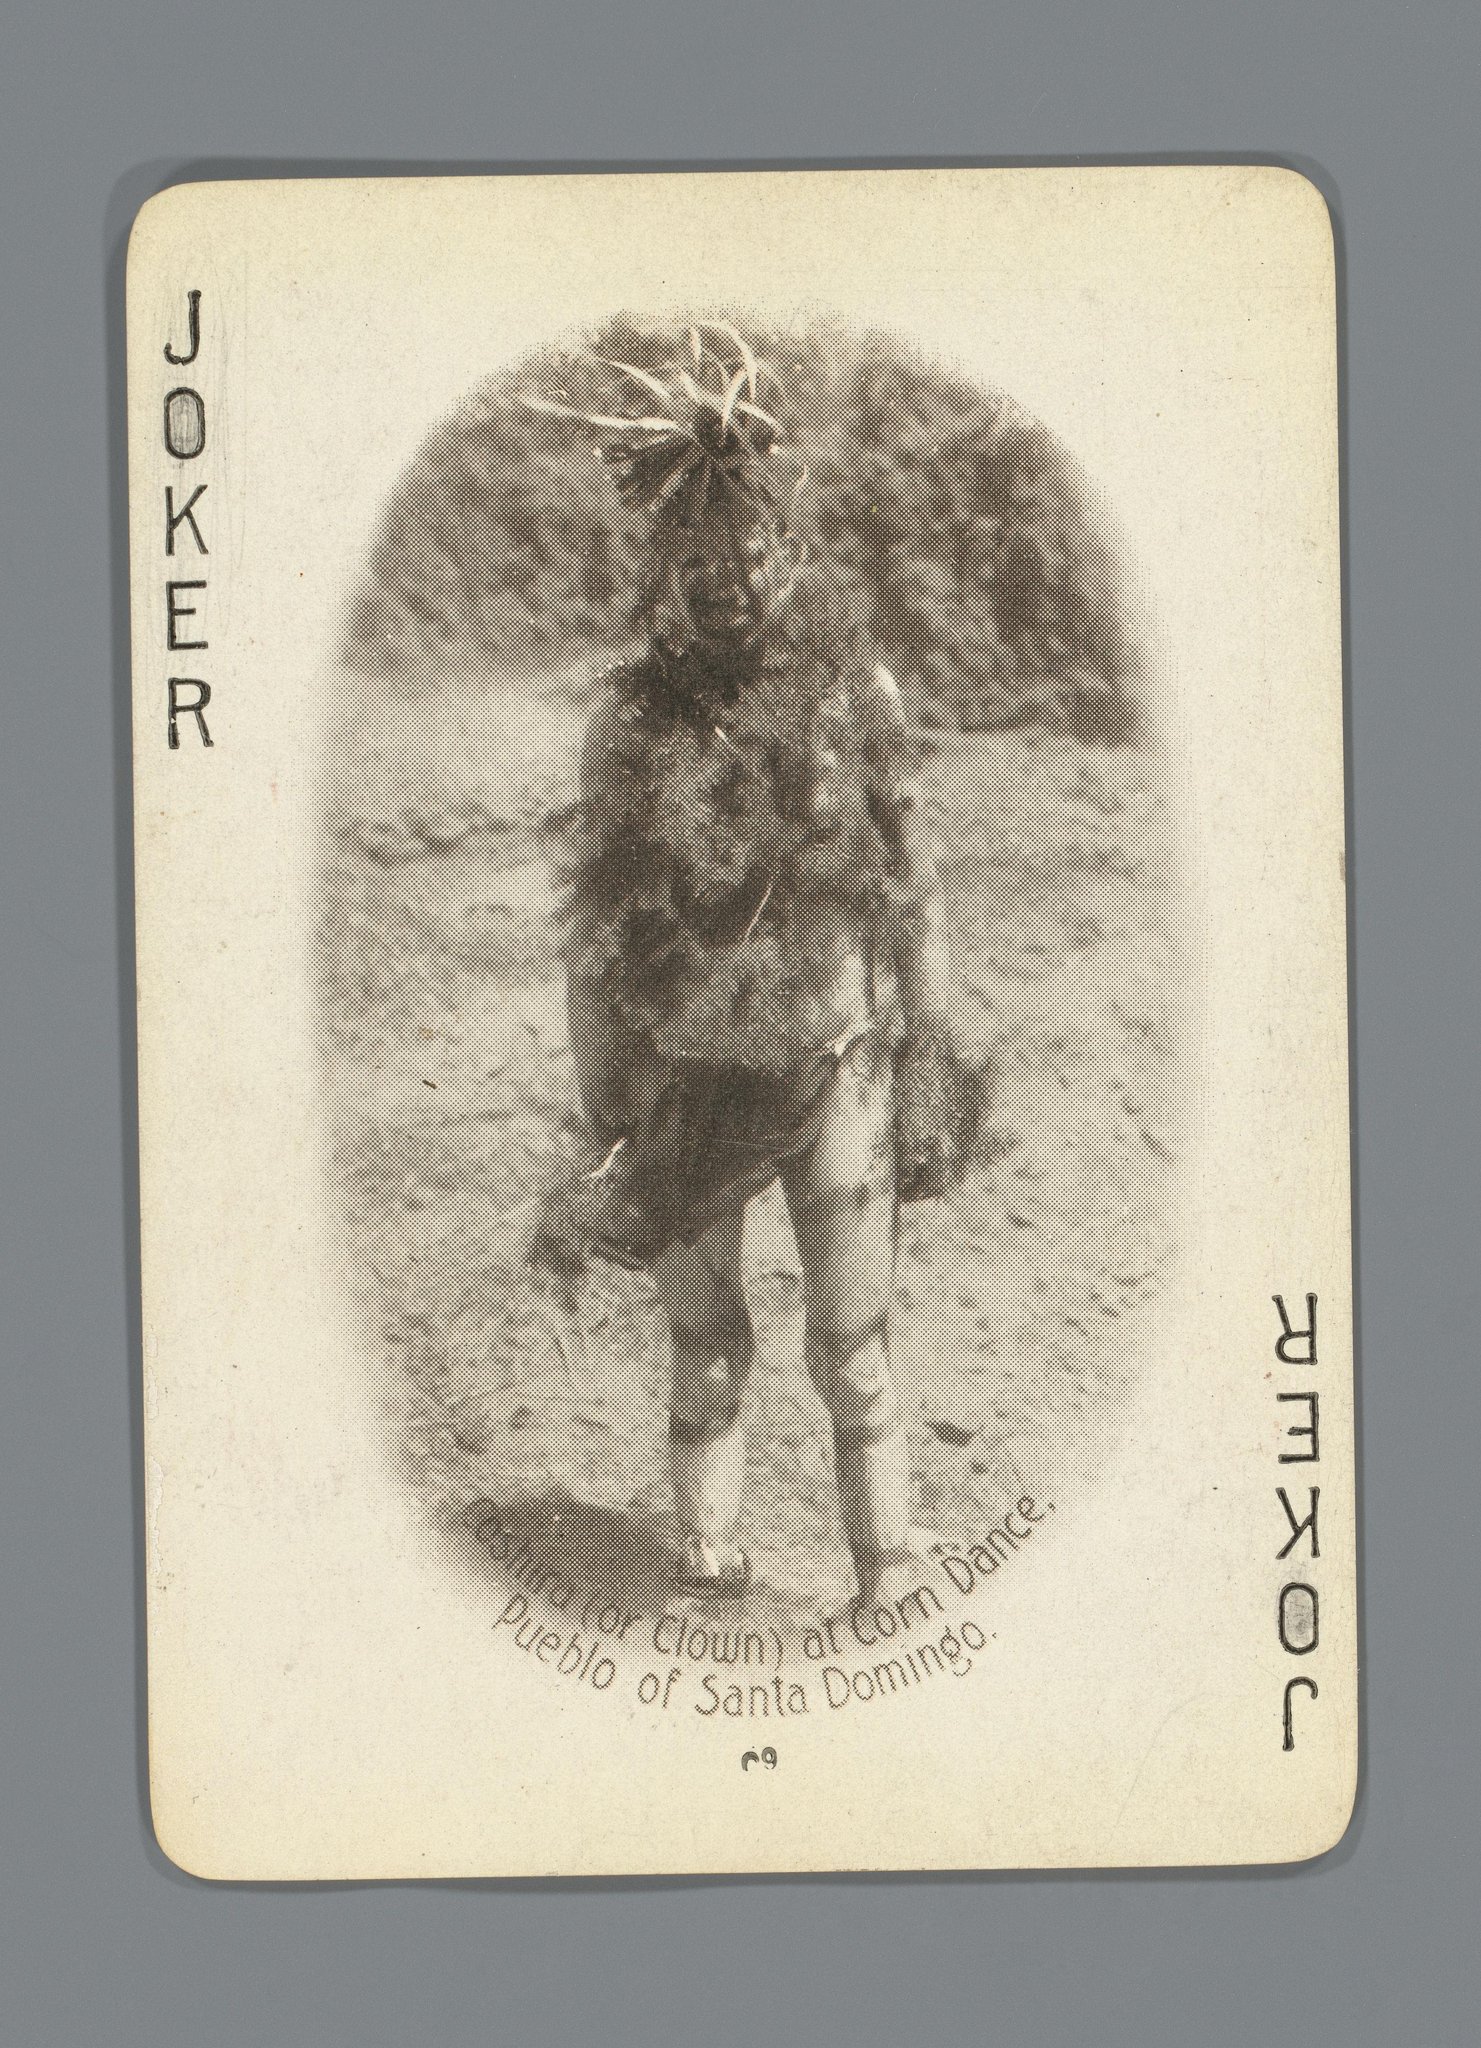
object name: photograph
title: Coshira (or Clown) at Corn Dance. Pueblo of Santa Domingo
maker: adam clark vroman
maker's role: fotograaf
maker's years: 1856-1916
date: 1900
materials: paper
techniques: autotype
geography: los angeles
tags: new mexico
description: Speelkaart uit doosje met 53 speelkaarten met afbeeldingen in autotypie van Native Americans. De inhoud bevat een complete set speelkaarten inclusief joker.